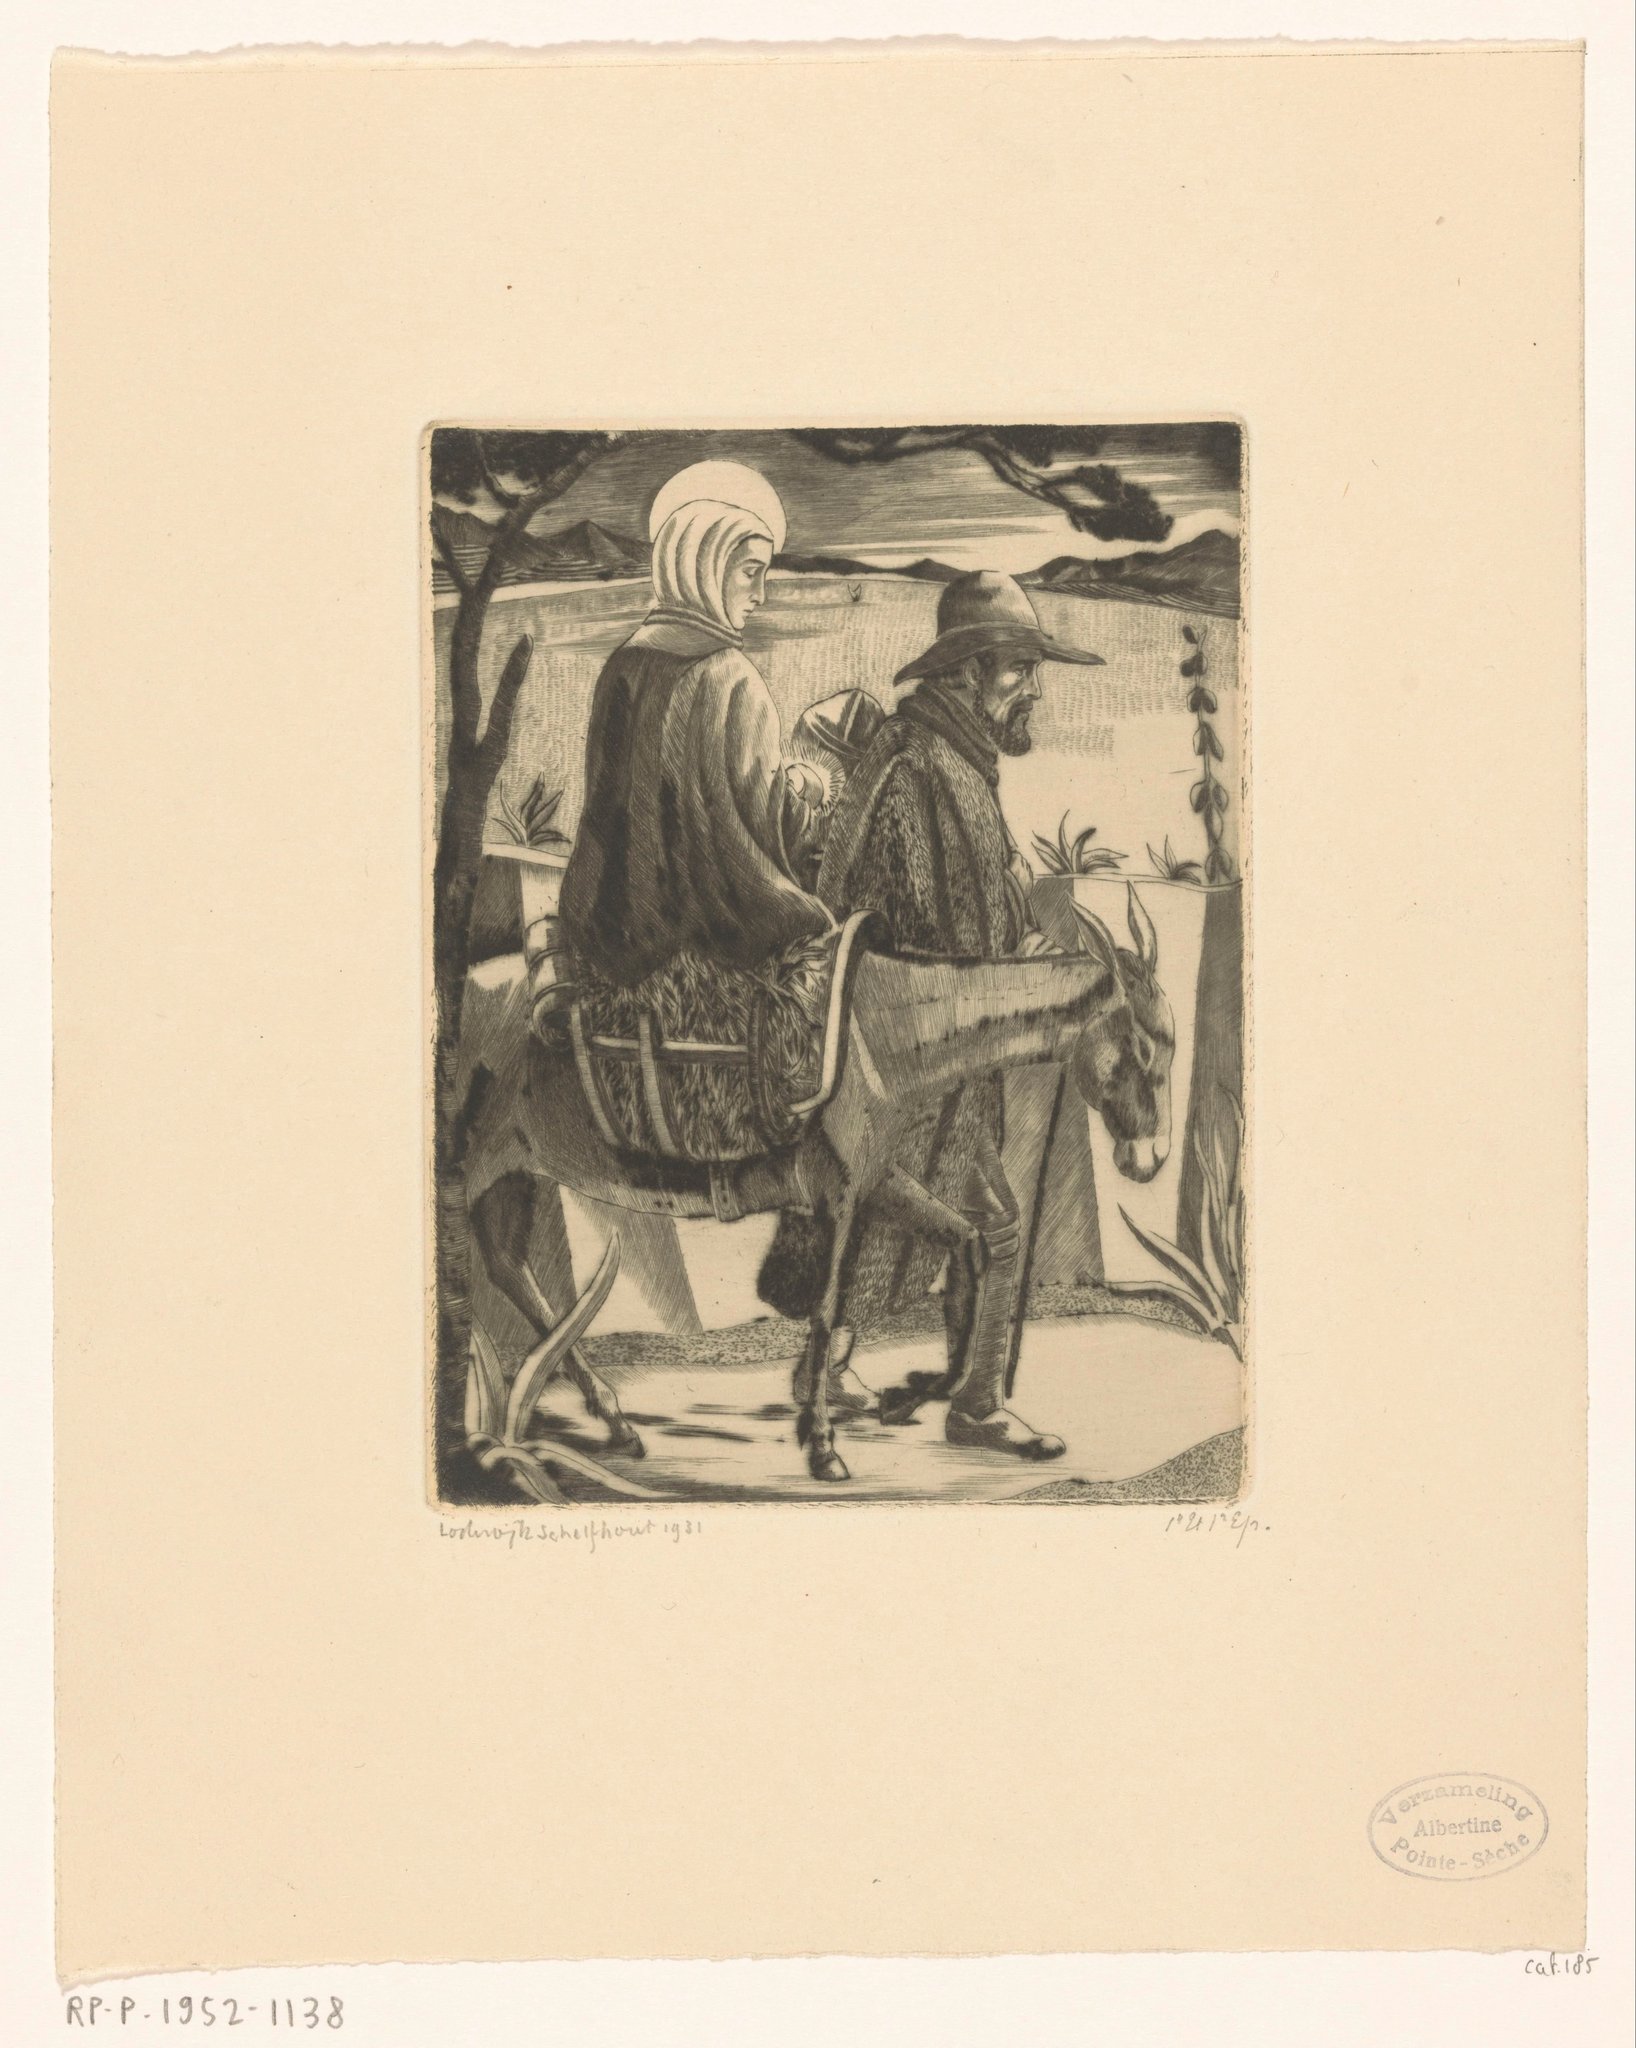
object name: print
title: Vlucht naar Egypte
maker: lodewijk schelfhout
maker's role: draughtsman, print maker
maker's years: 1881-1943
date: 1931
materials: paper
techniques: drypoint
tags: the flight into egypt: mary, joseph, the child (and sometimes others) on their way; mary usually riding on an ass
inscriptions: collector's mark: Lugt 5i, collector's mark: Lugt 2228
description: Maria rijdend op een ezel in een berglandschap met een meer. Ze draagt het Christuskind in haar armen. Naast hen loopt Jozef.